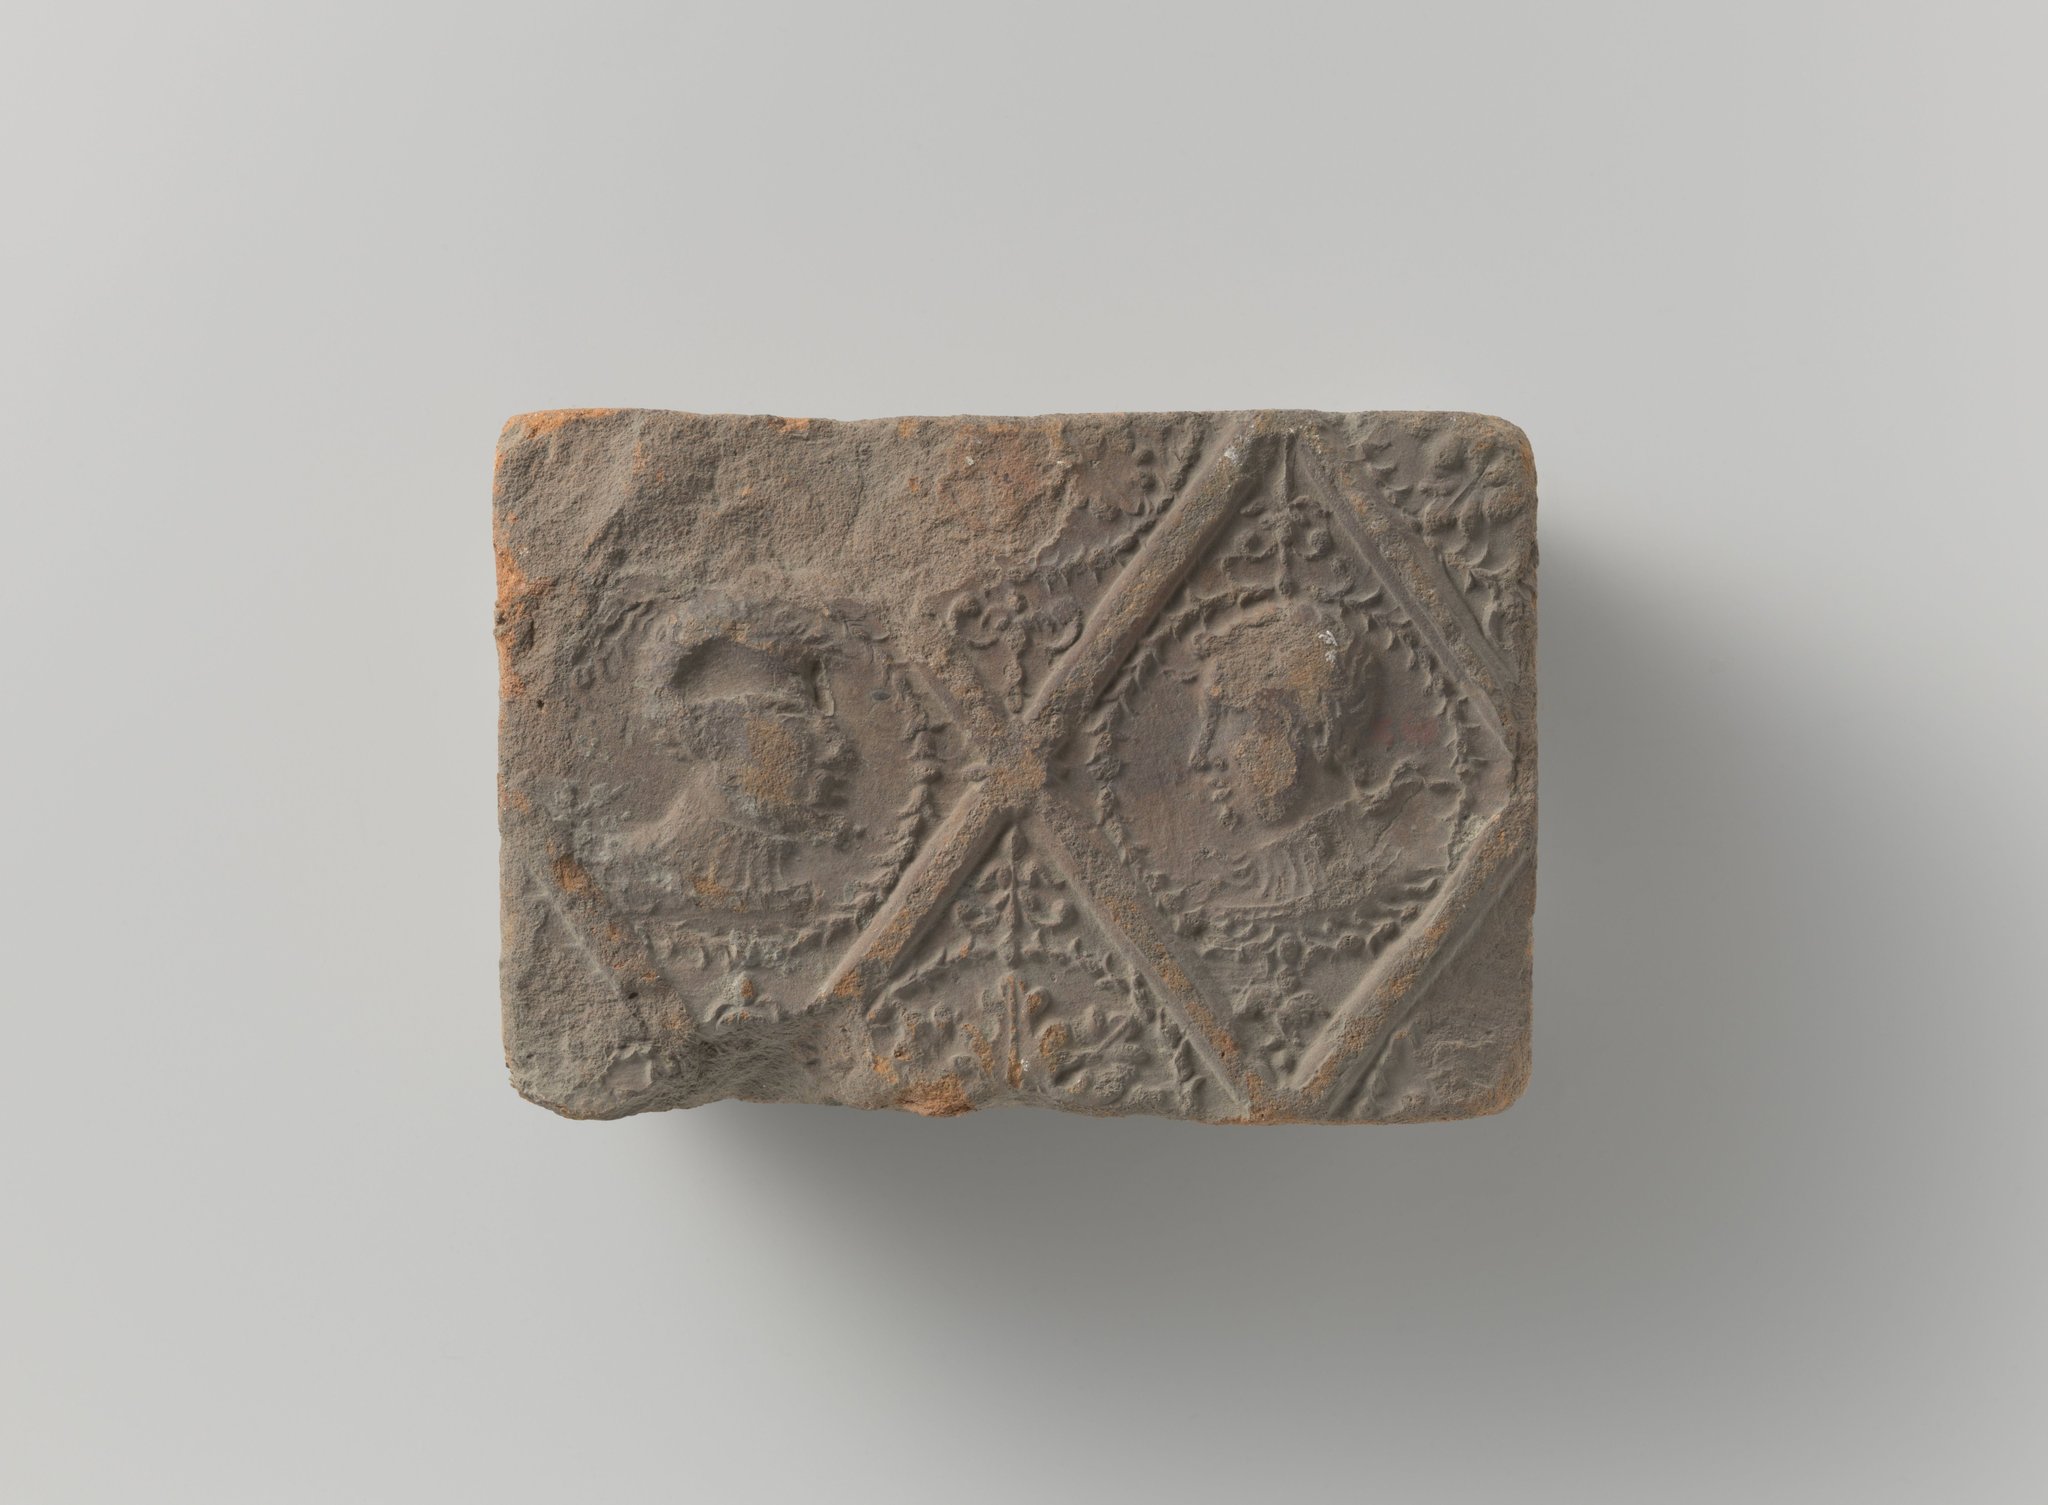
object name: hearthstone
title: Haardsteen met een voorstelling van twee manskoppen in ruiten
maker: Anonymous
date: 1499-1699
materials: earthenware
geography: southern netherlands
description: Haardsteen met een voorstelling van twee manskoppen in ruiten